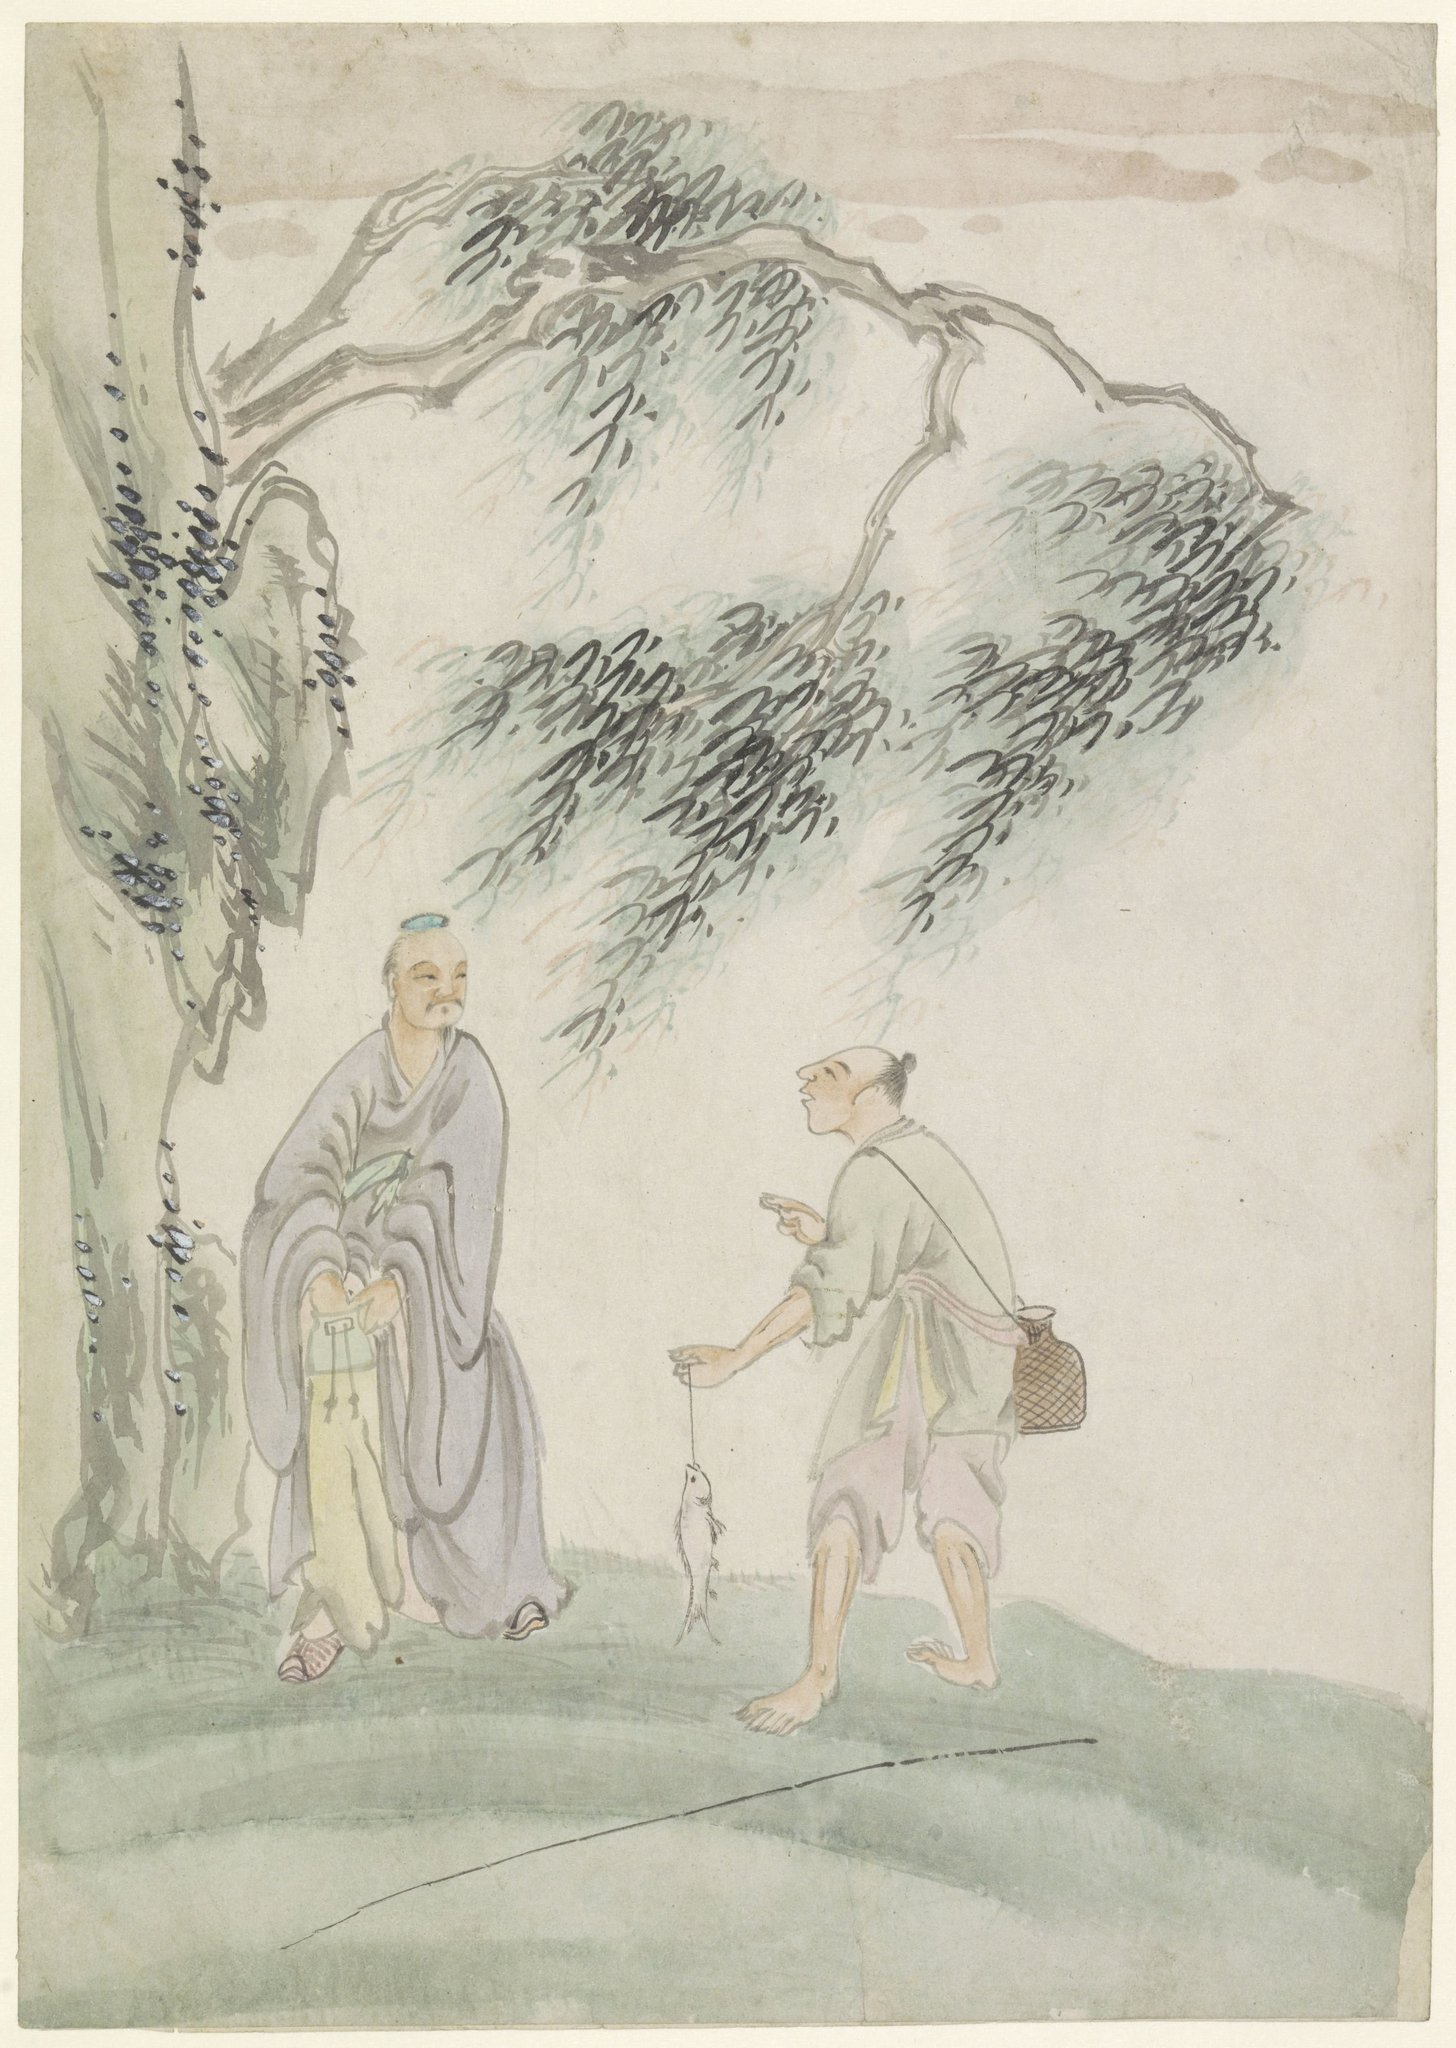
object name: drawing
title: Wandelaar die een vis koopt van een visser, onder een boom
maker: Anonymous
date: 1800-1899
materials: ink, paper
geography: china